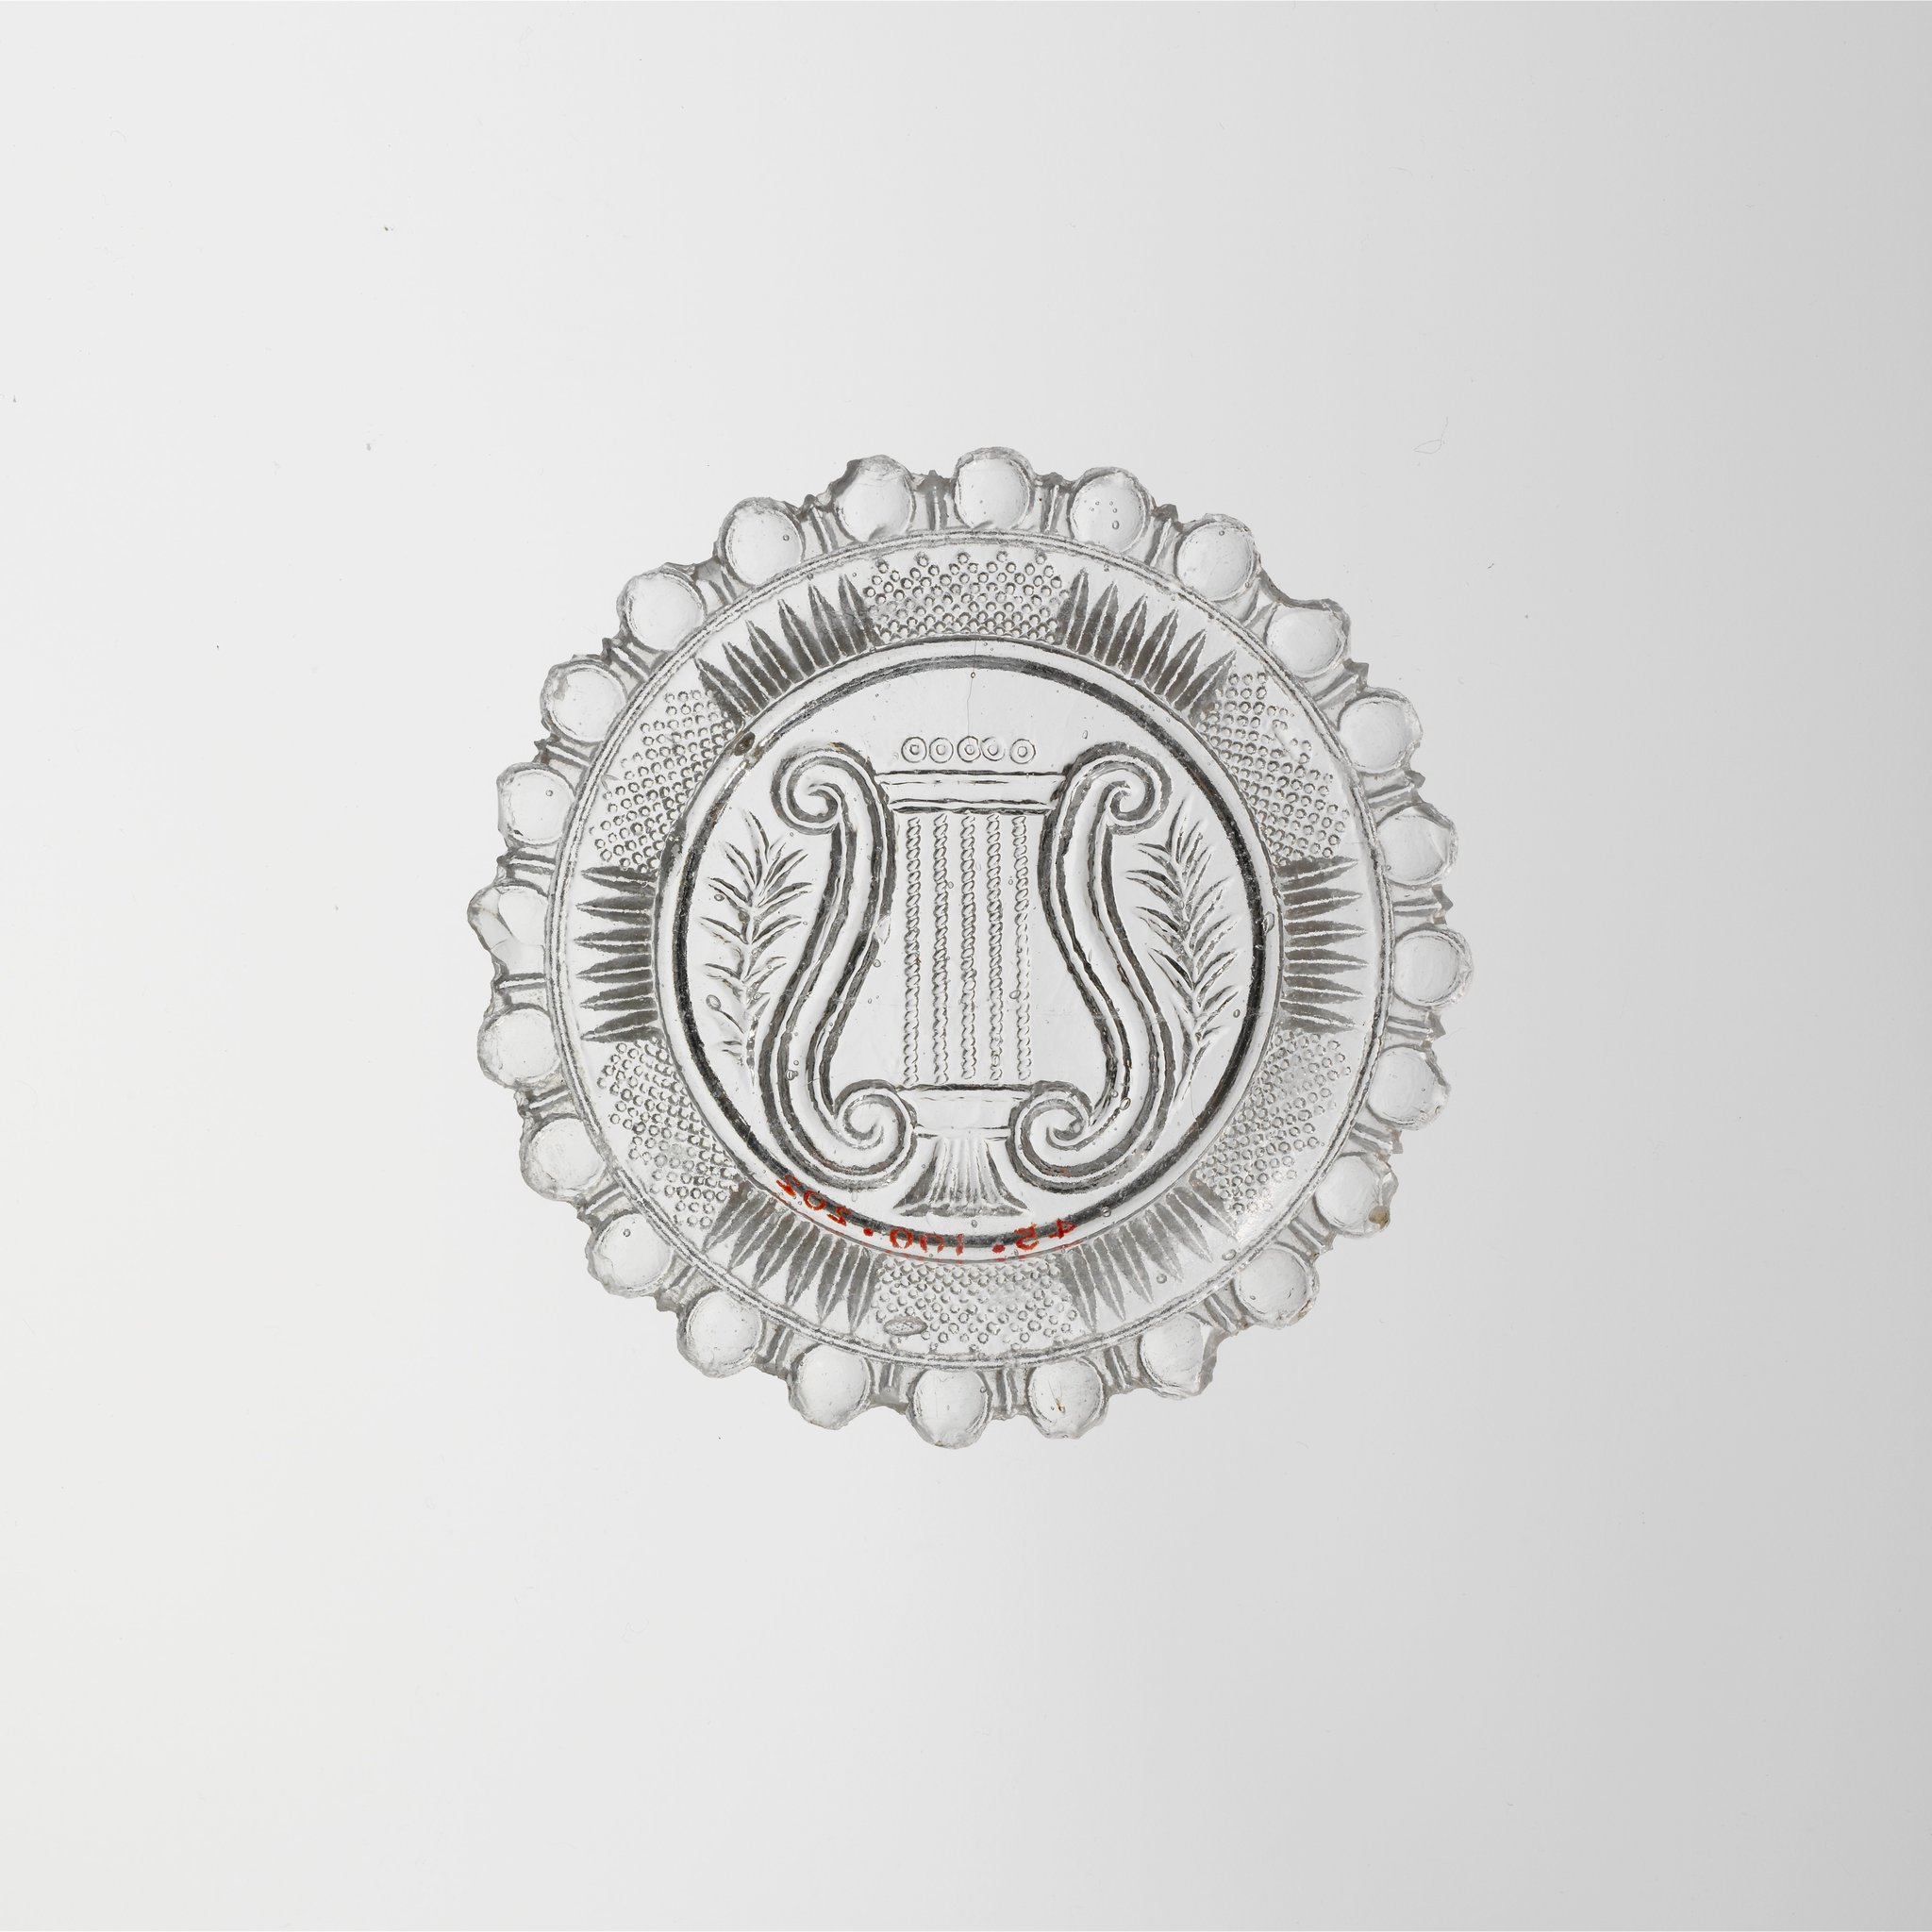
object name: cup plate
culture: american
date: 1825-1860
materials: glass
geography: united states